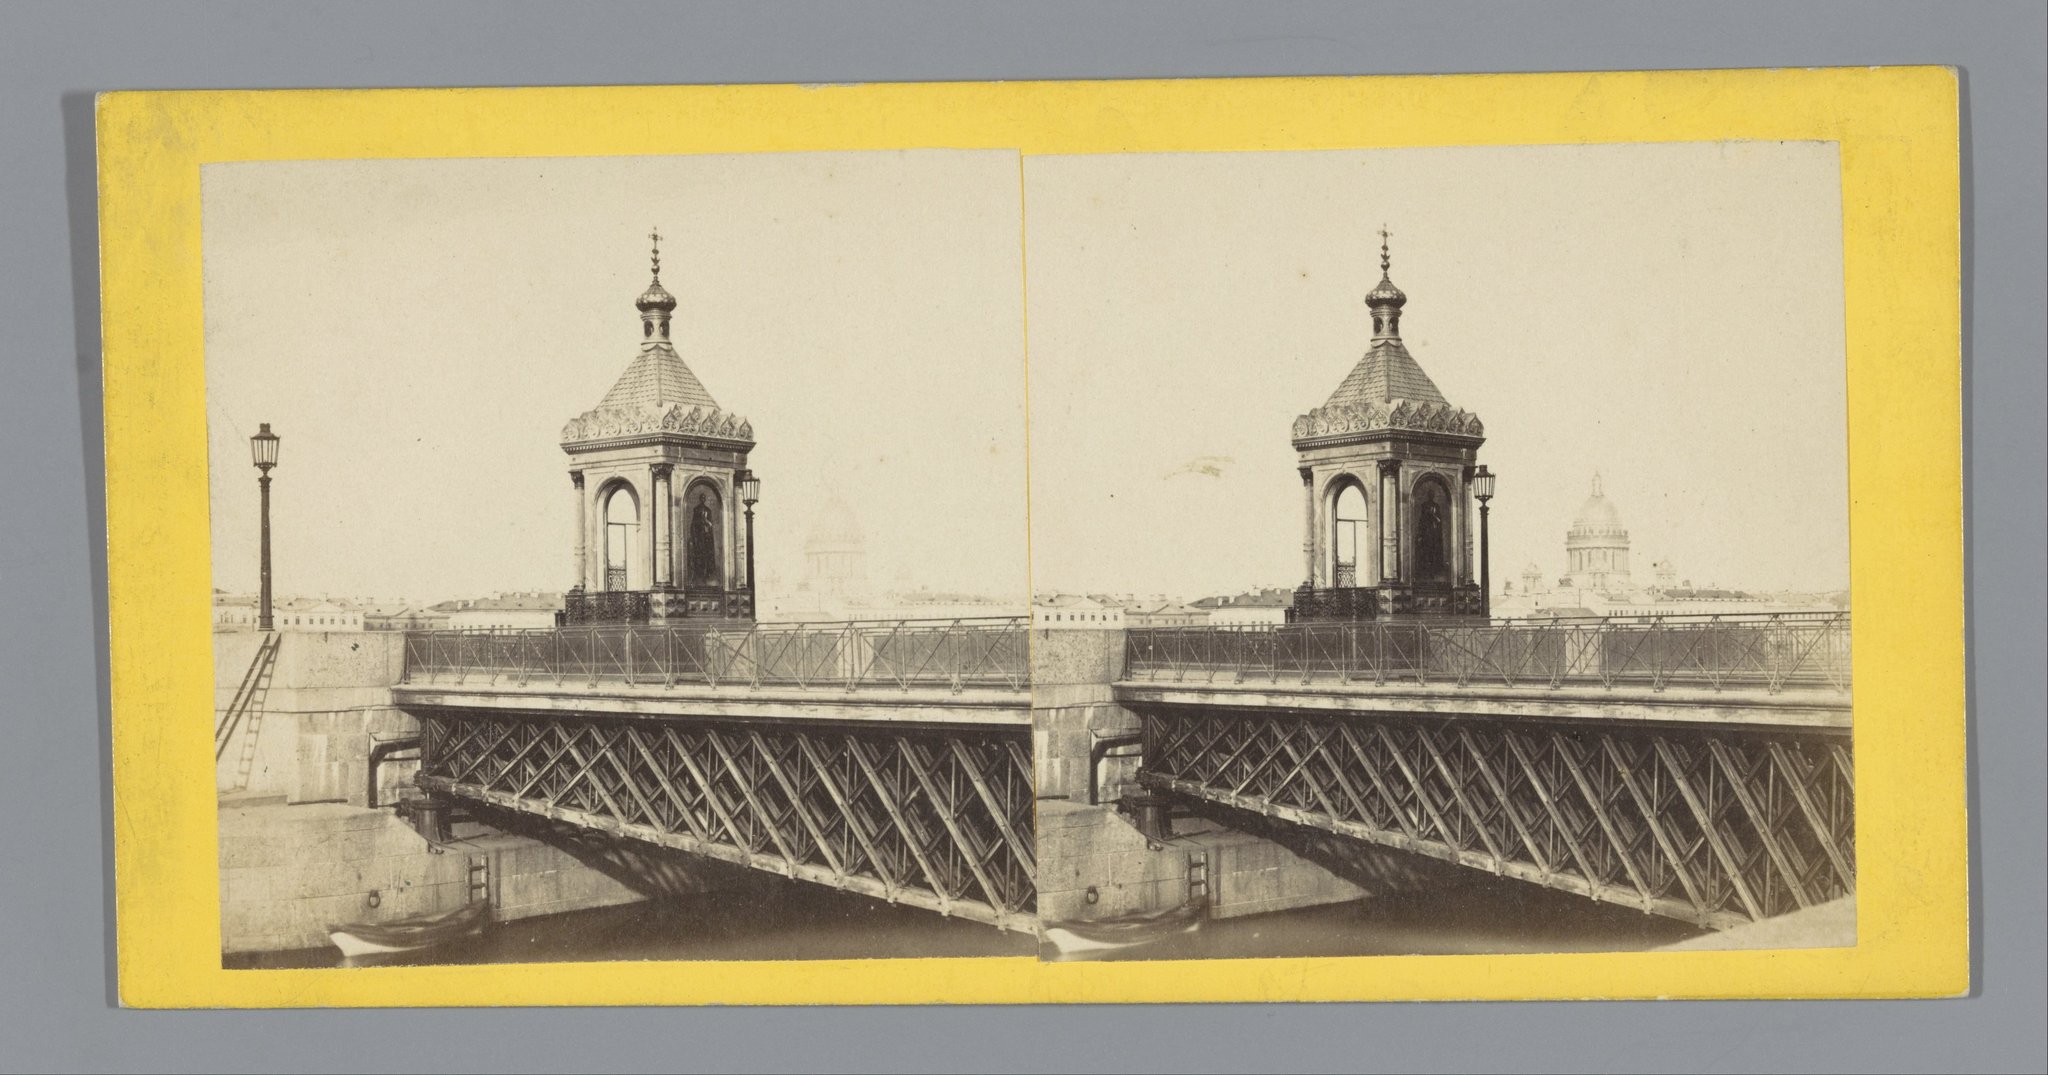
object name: stereograph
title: Gezicht op de Nicolaaskapel op de Nicolaasbrug in Sint-Petersburg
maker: Anonymous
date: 1850-1880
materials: cardboard, photographic support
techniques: albumen print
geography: sint-petersburg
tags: church (exterior) - qq - small church, chapel, bridge in city across river, canal, etc.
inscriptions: inscription: ‘21 Chapelle Sur le Pont neuf St. Pétersbourg Russie’